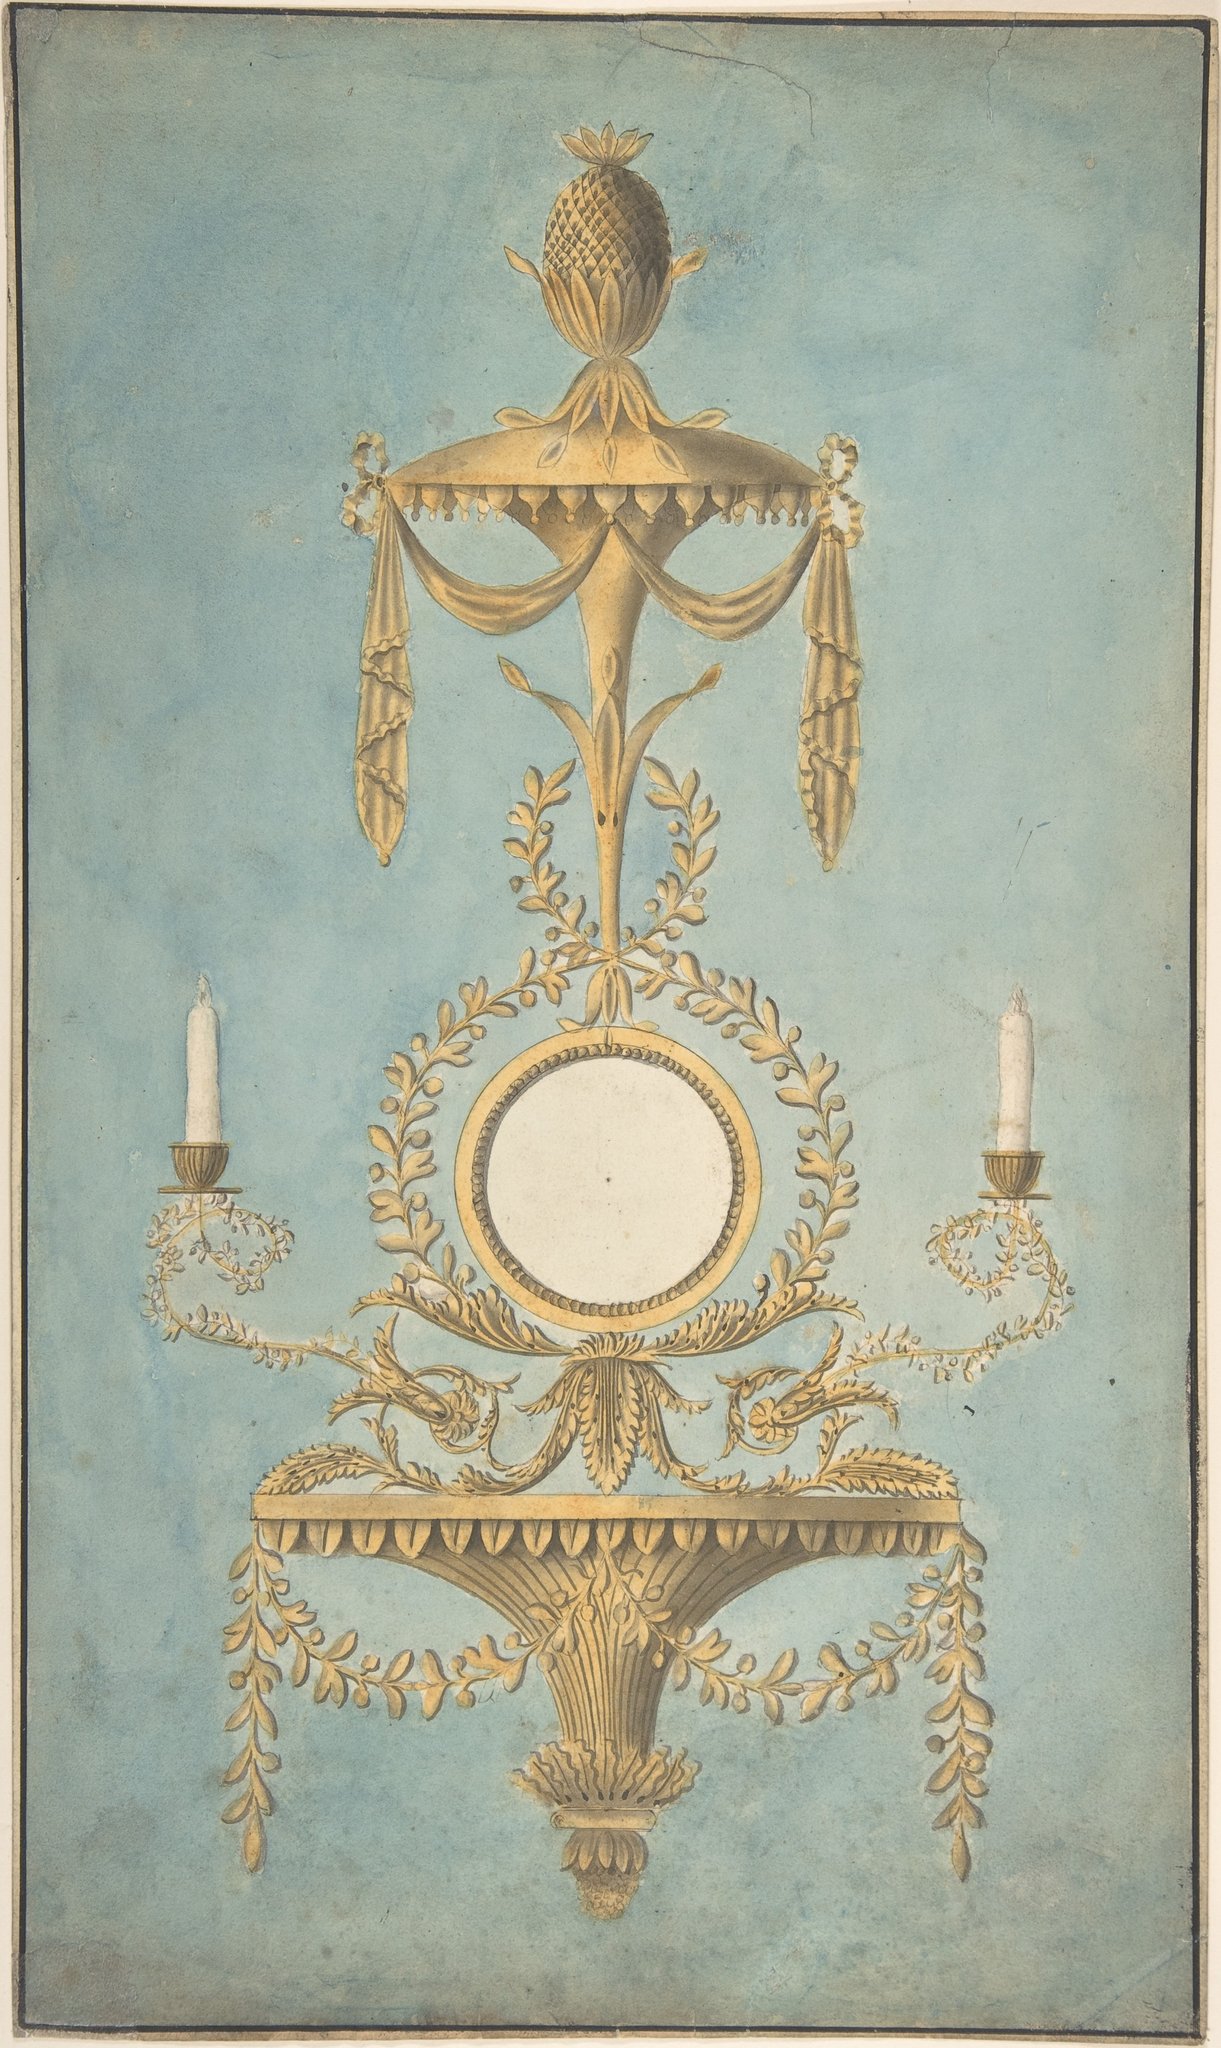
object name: drawing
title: Design for a Sconce with a Mirror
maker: john yenn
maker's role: artist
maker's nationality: british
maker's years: 1750-1821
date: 1767-1833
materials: ink, watercolor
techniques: pen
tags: mirrors